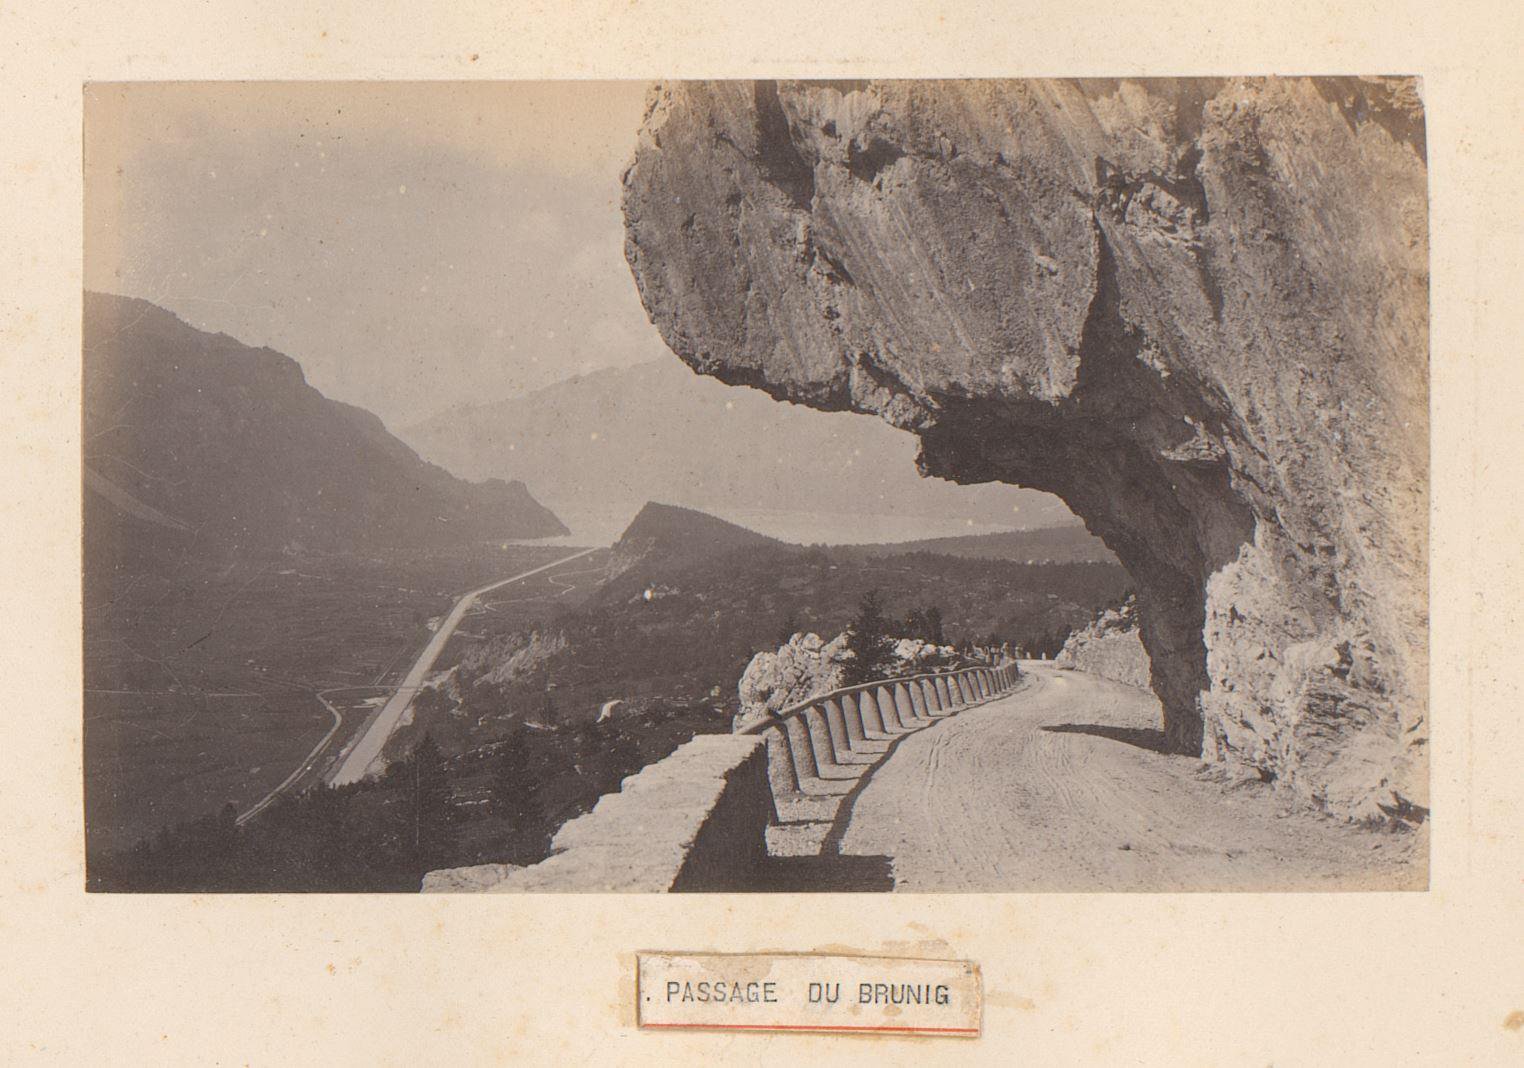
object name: photograph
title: Passage du Brunig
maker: Anonymous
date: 1860-1890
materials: paper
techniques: albumen print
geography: brünigpas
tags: road, path, mountains